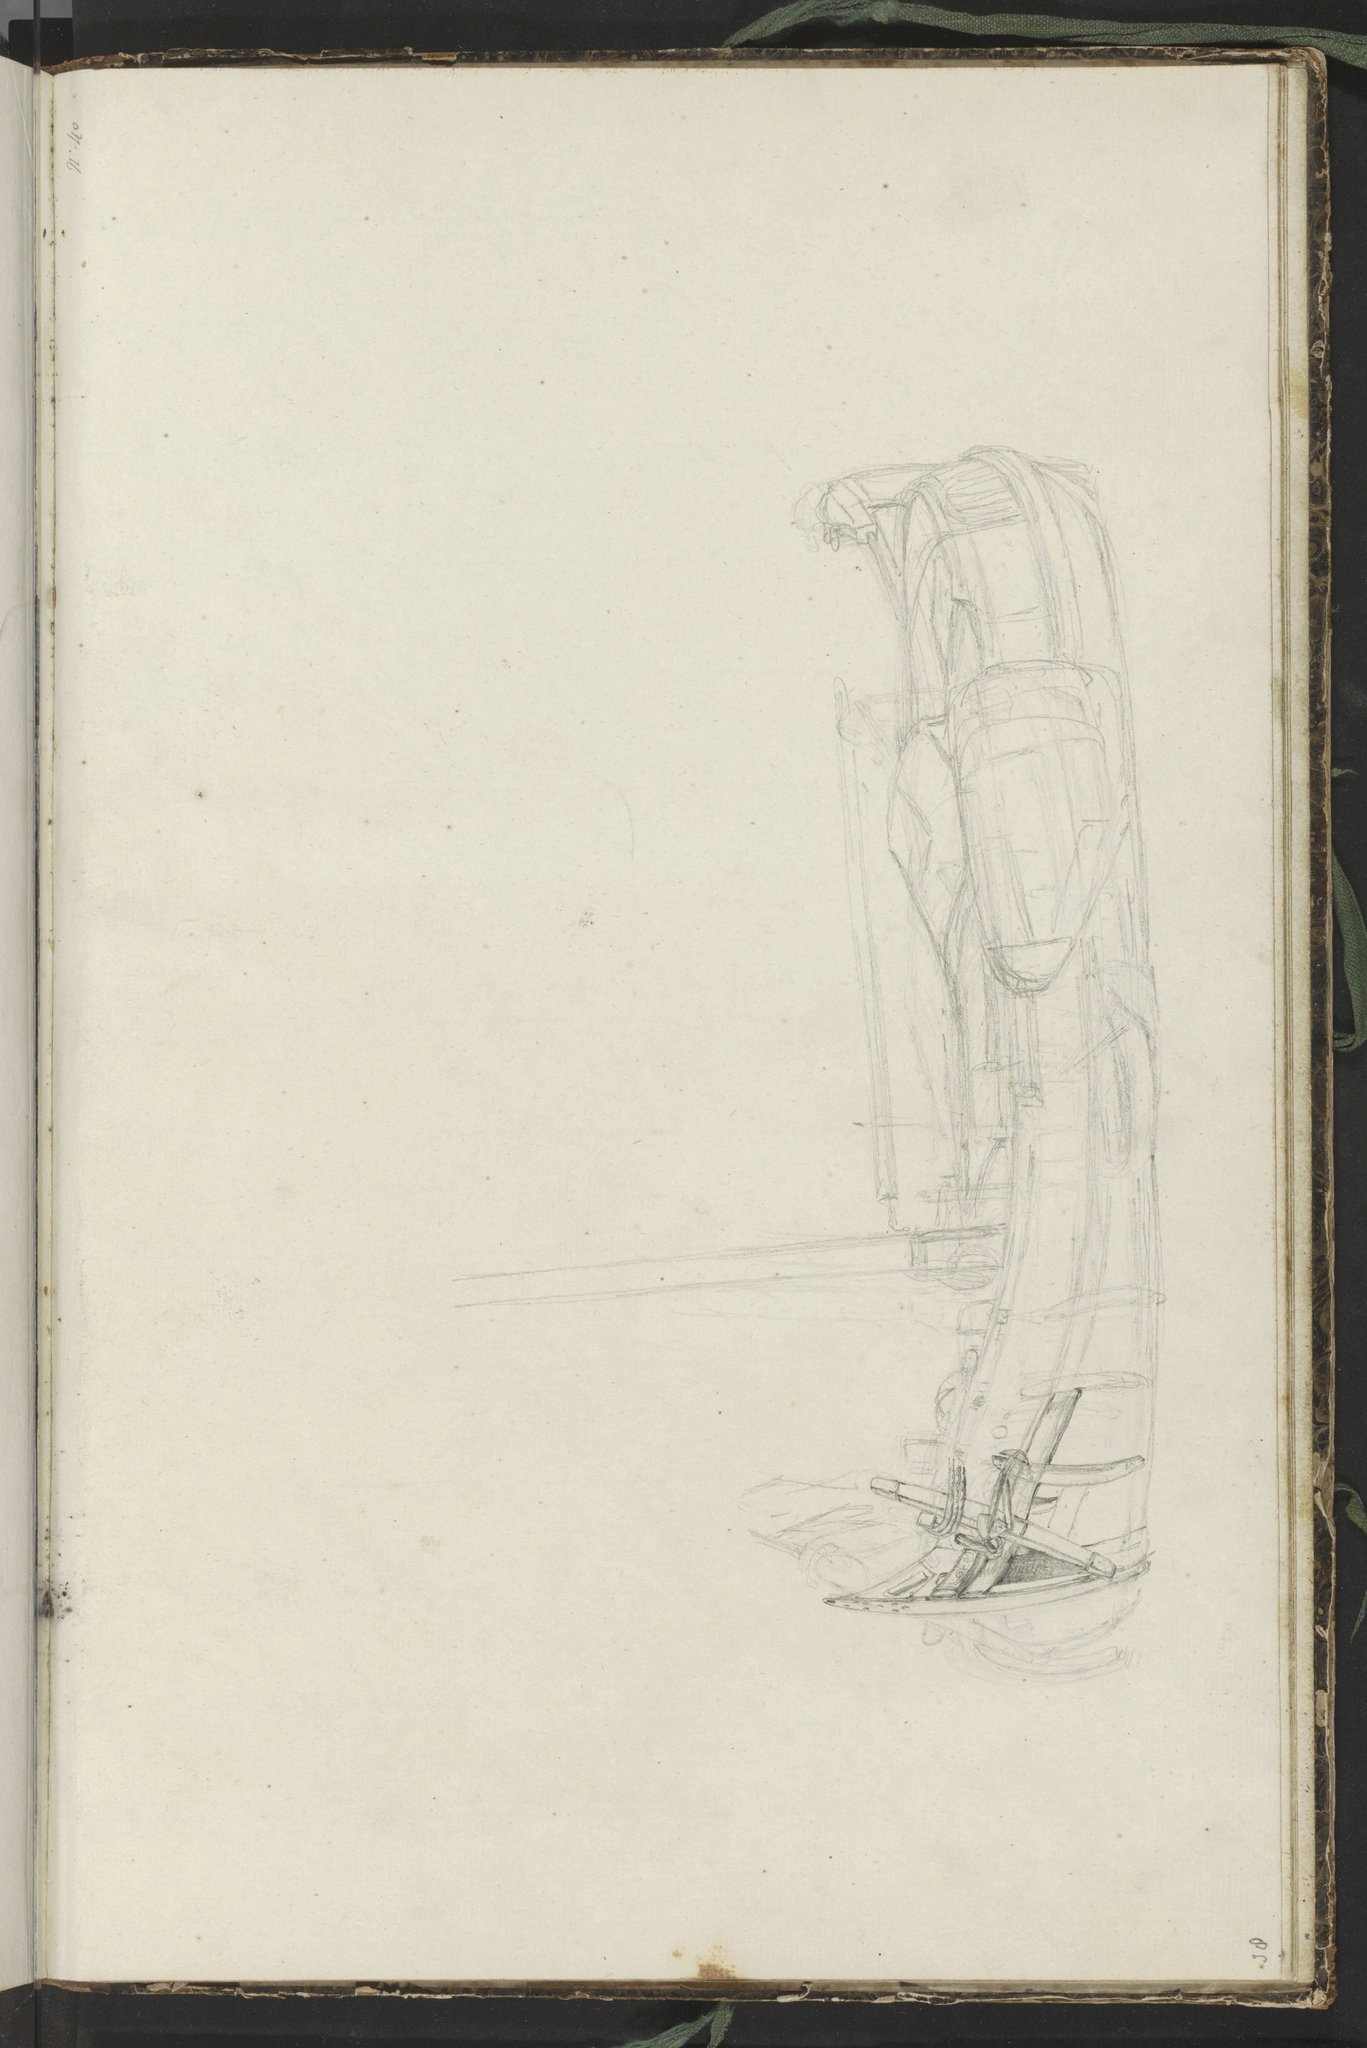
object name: sketchbook leaf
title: Zeilboot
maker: johannes christiaan schotel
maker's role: draughtsman, painter, print maker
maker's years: 1787-1838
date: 1797-1838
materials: paper, pencil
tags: sailing-ship, sailing-boat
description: Blad 38 recto uit een schetsboek met 44 bladen.